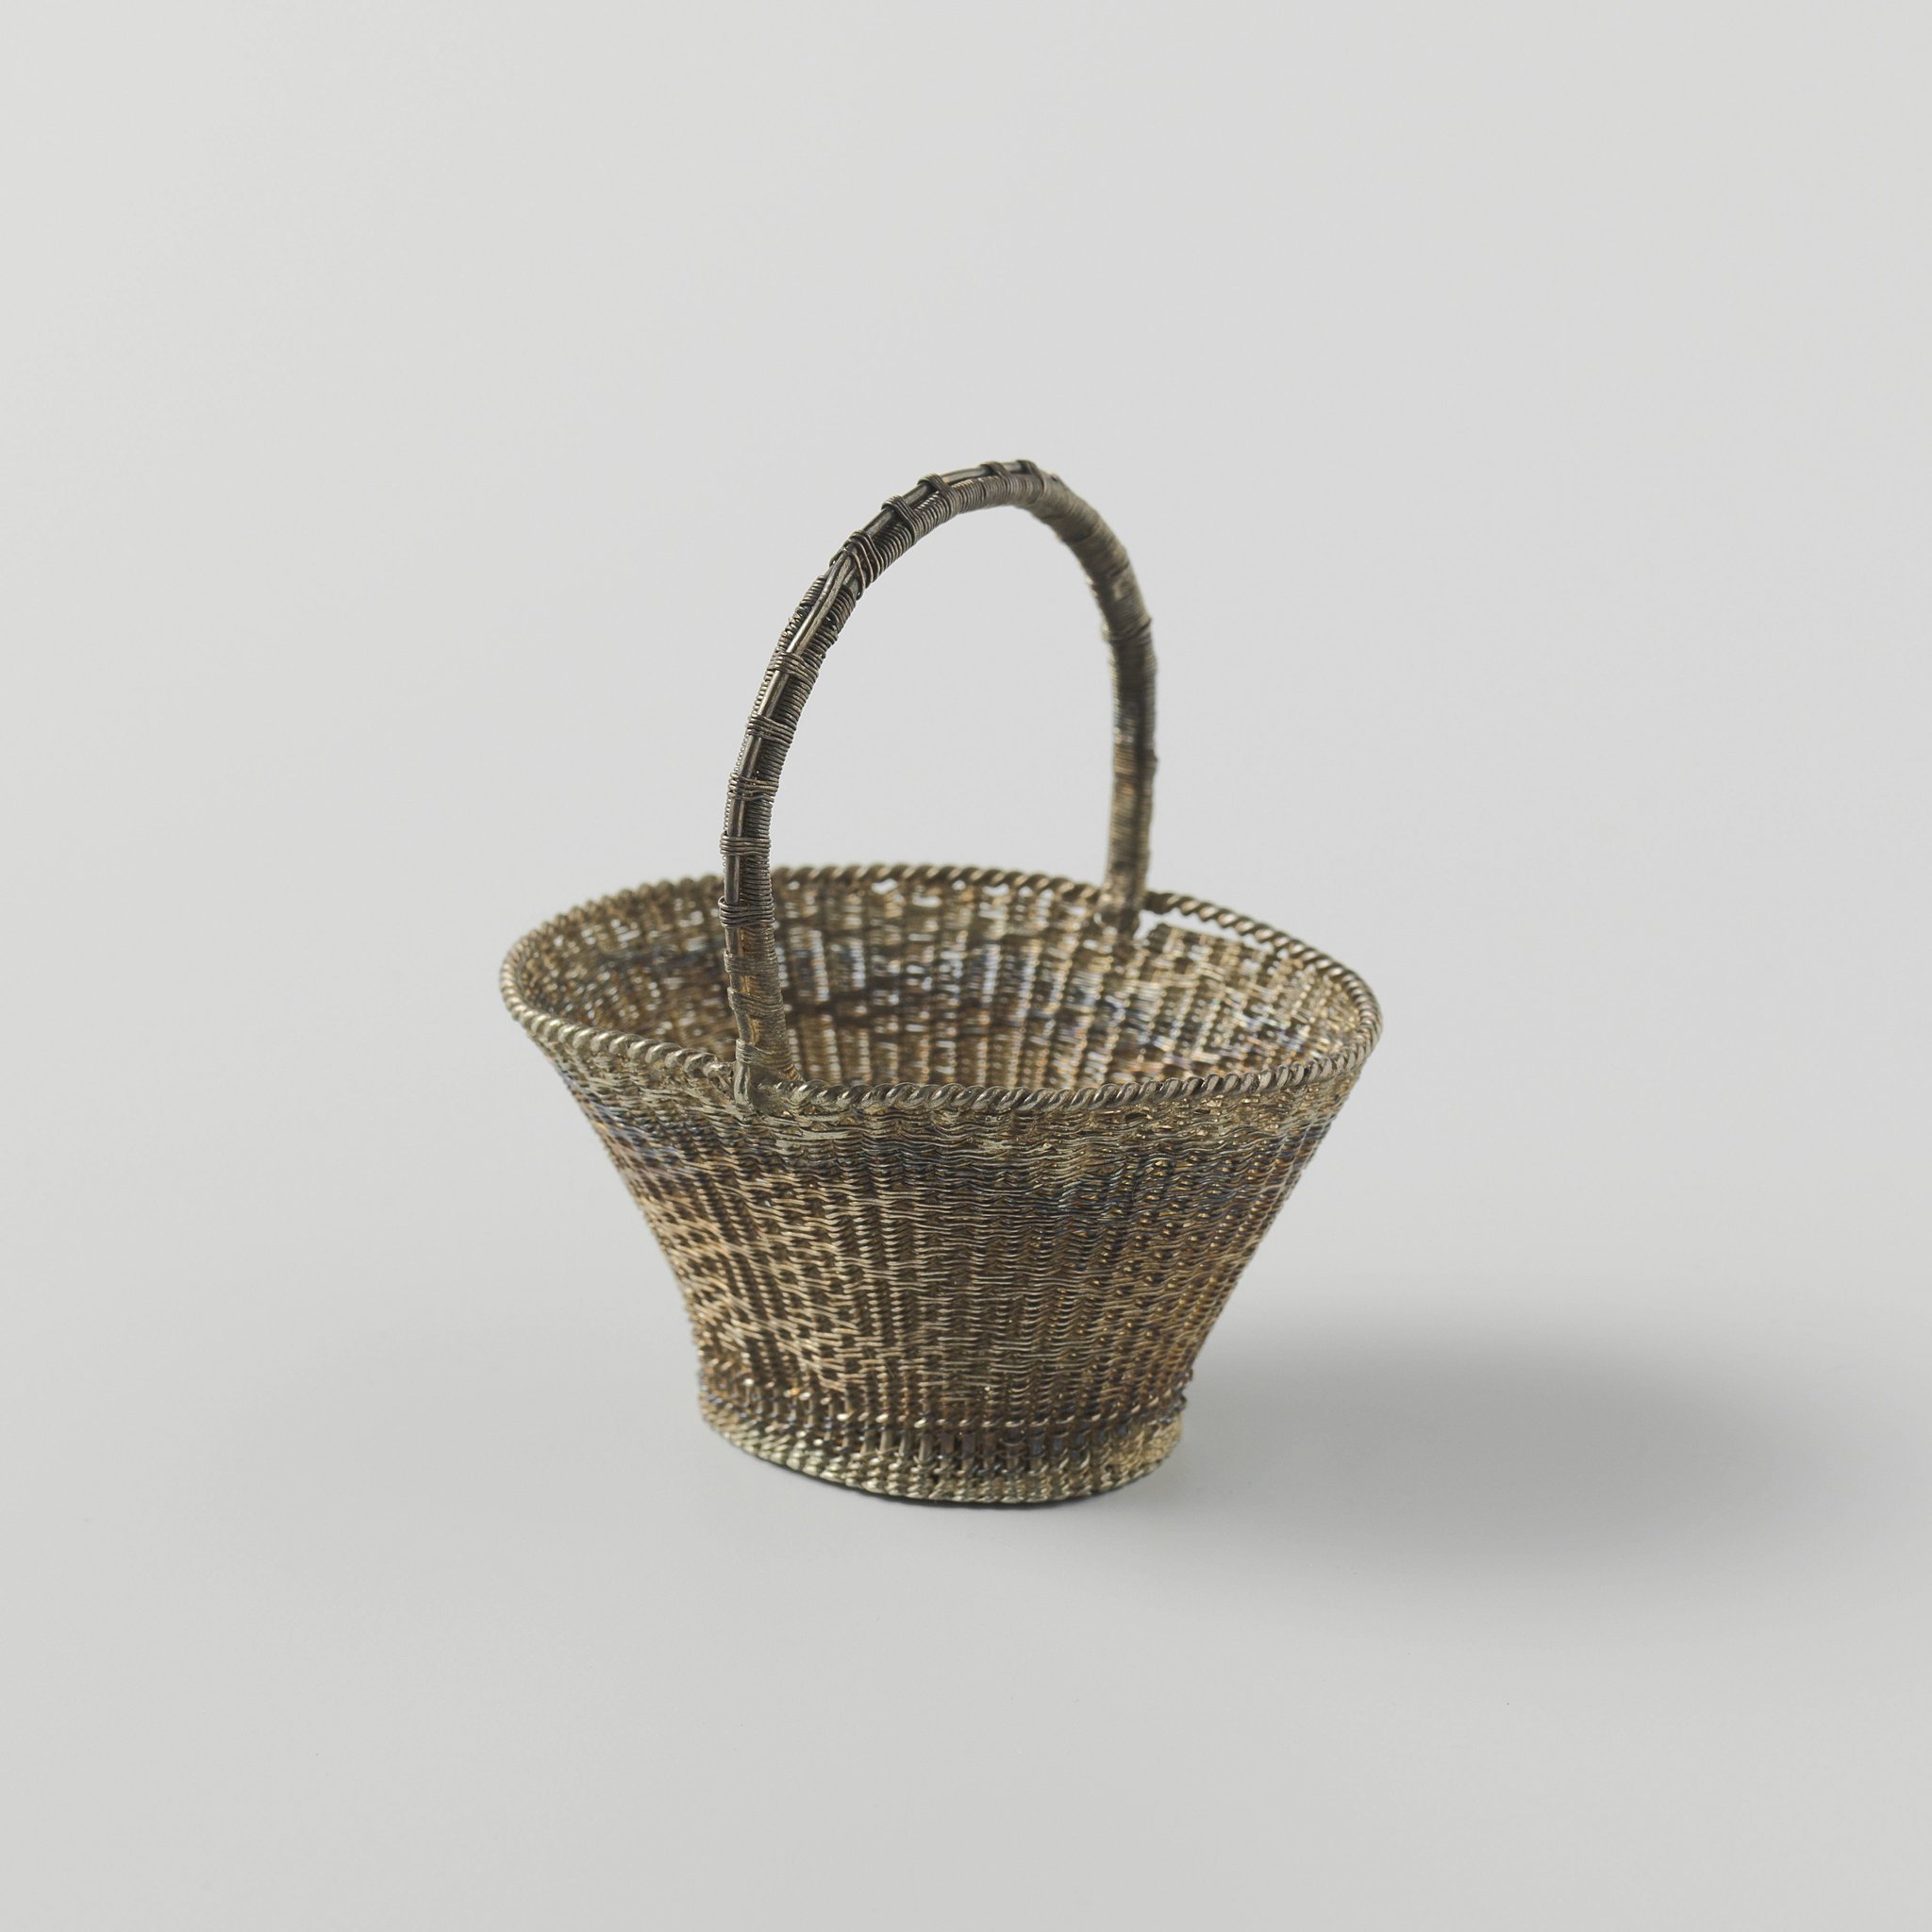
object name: miniature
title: Hengselmand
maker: Anonymous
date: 1725-1750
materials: silver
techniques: filigree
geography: netherlands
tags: container made of plant material other than wood: basket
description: Ovale hengselmand van gevlochten zilverdraad. De mand heeft een vast hengsel. De mand loopt naar boven toe wijd uit en is niet gemerkt.